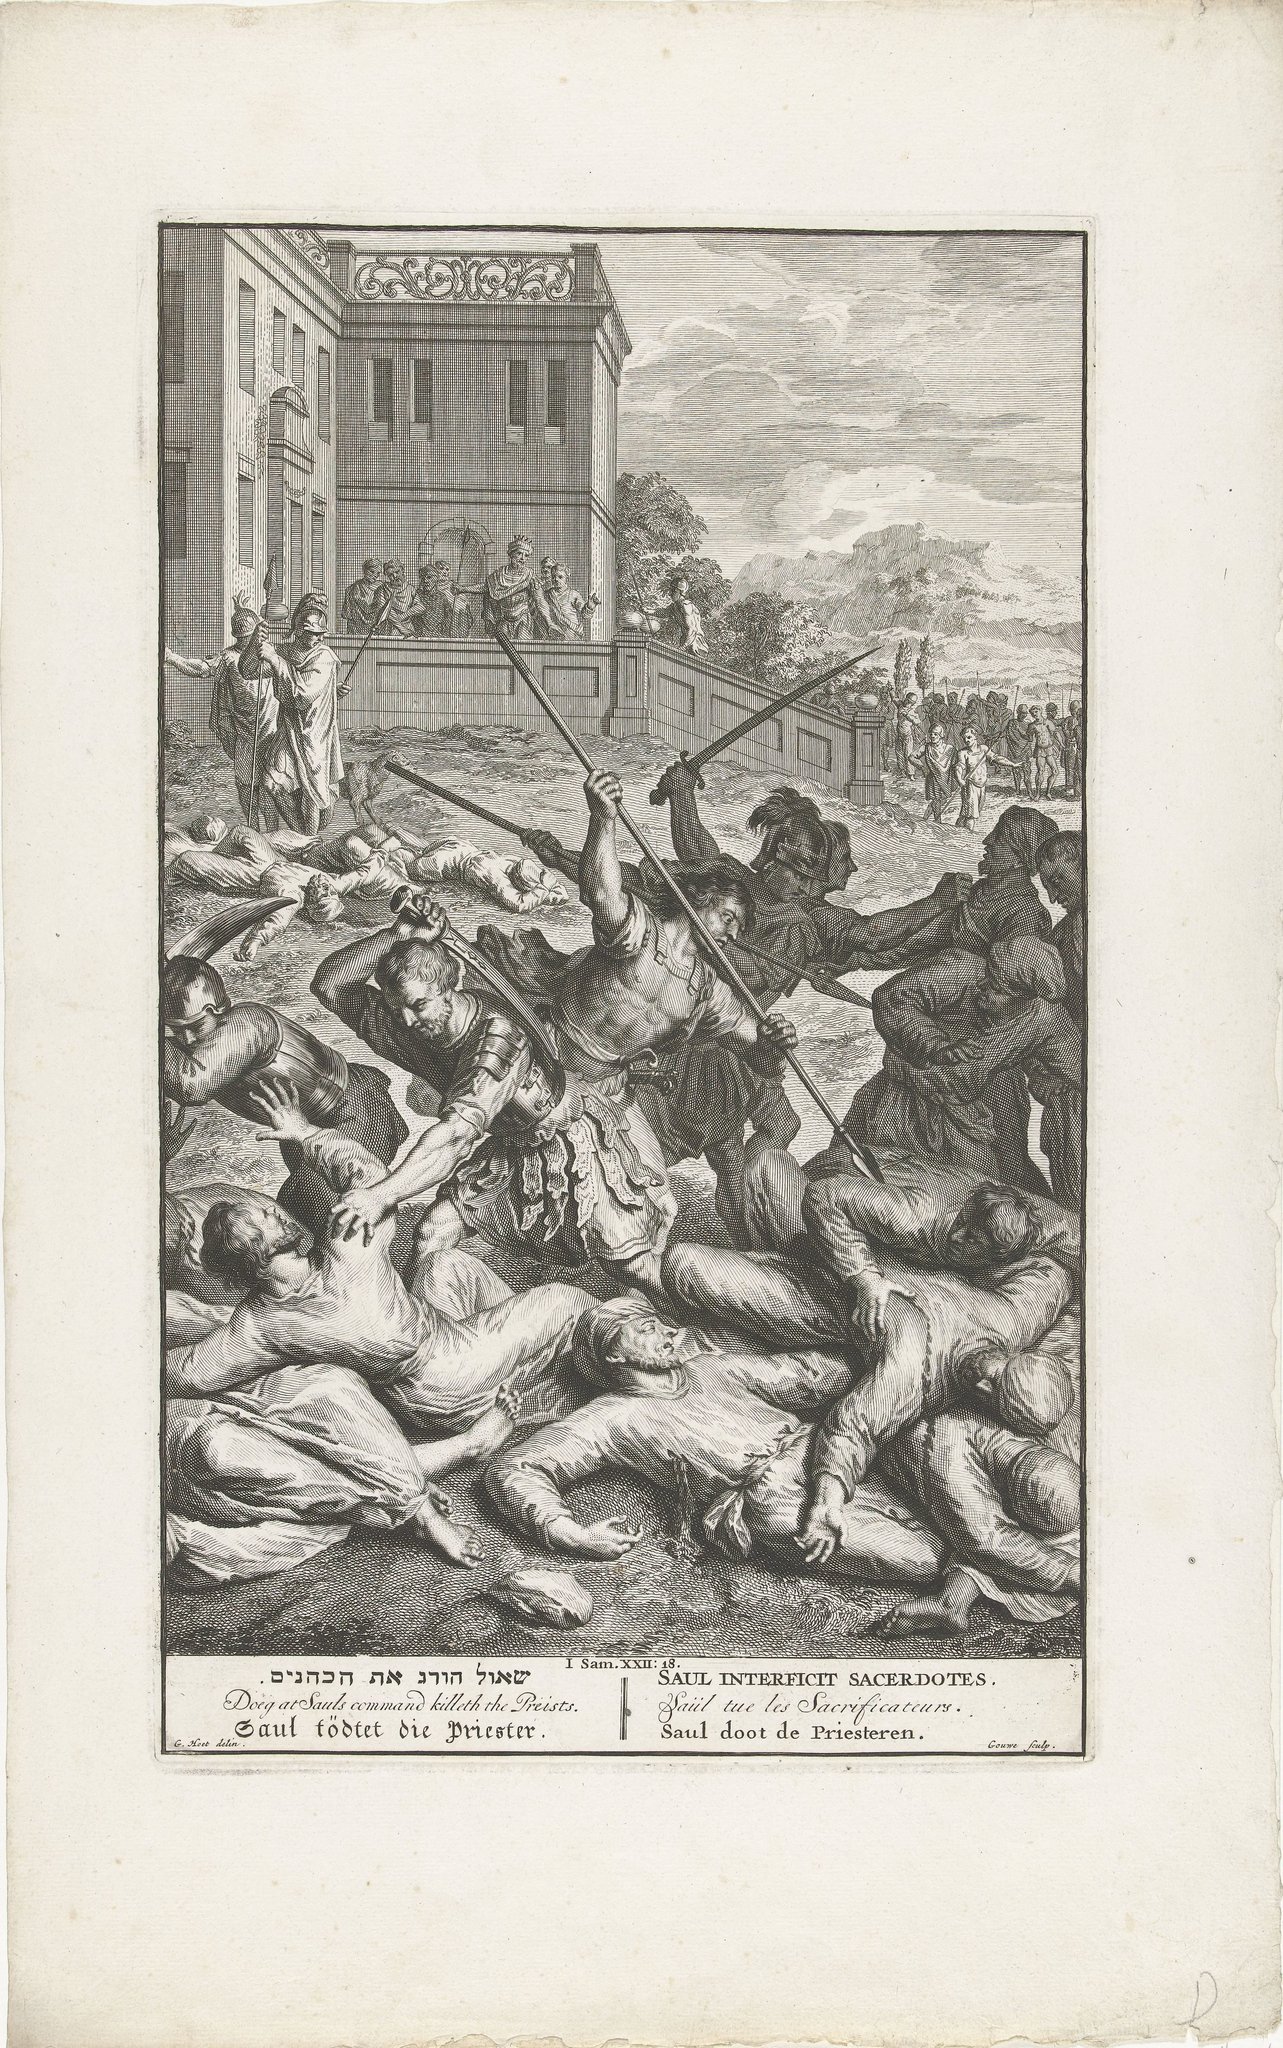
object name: print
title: Saul wreekt zich op de priesters van Nob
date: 1728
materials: paper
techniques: engraving, etching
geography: amsterdam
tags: the inhabitants of nob are killed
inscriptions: caption: ‘Utrechts fundatie huys’, collector's mark: Lugt 2228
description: Saul beveelt zijn lijfwacht de priesters van Nob te vermoorden vanwege hun hulp aan David. Op de voorgrond worden de priesters en hun familieleden afgeslacht. Op de achtergrond rechts de lijfwachten die geweigerd hebben Sauls bevel uit te voeren (1 Sam. 22:18). De prent heeft een Hebreeuws, Latijns, Frans, Engels, Duits en Nederlands onderschrift.